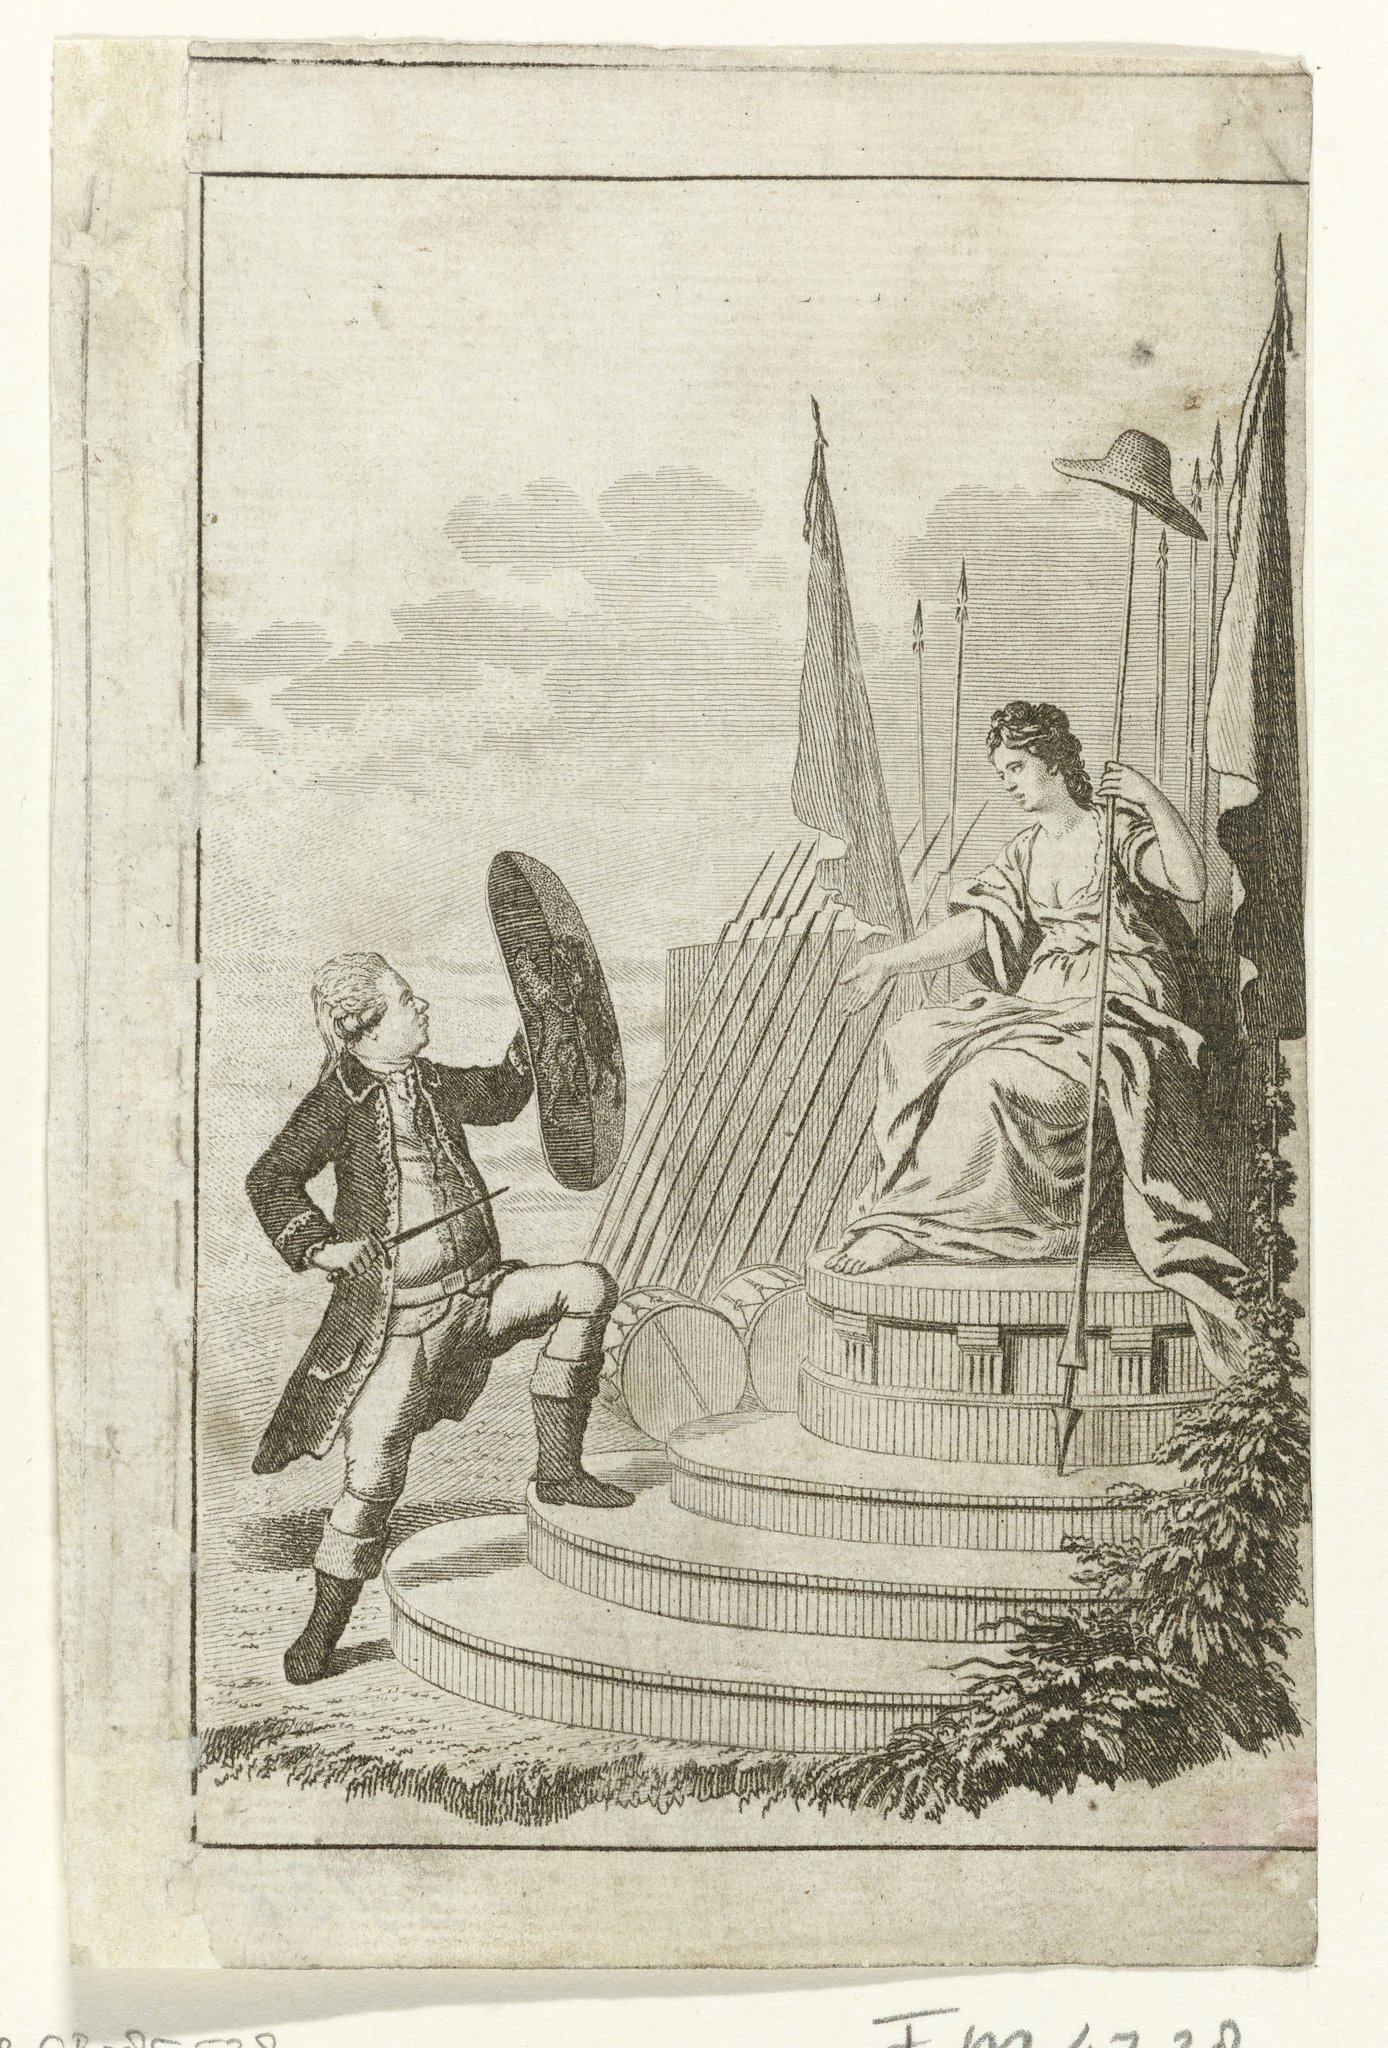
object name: print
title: Willem V bedreigt de Vrijheid, 1786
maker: Anonymous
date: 1786-1795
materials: paper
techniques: engraving, etching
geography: northern netherlands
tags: the hague, william v (prince of orange), freedom, liberty; 'libertà' (ripa) (+ abstract concept represented by female figure)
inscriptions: collector's mark: Lugt 2228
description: Prins Willem V bestijgt, gewapend met dolk en schild, de troon waarop de Vrijheid zit, omringd door vaandels en geweren. Achter hem de Dwingelandij of het Verraad, die hem een dolk in de hand wil geven om de Vrijheid te doden. Naar aanleiding van de aanval op Hattem in september 1786. Bewerking van de oorspronkelijke plaat gebruikt als titelpagina voor het patriots treurspel: Willem de Vyfde, of de Wraakgierige uit 1786.